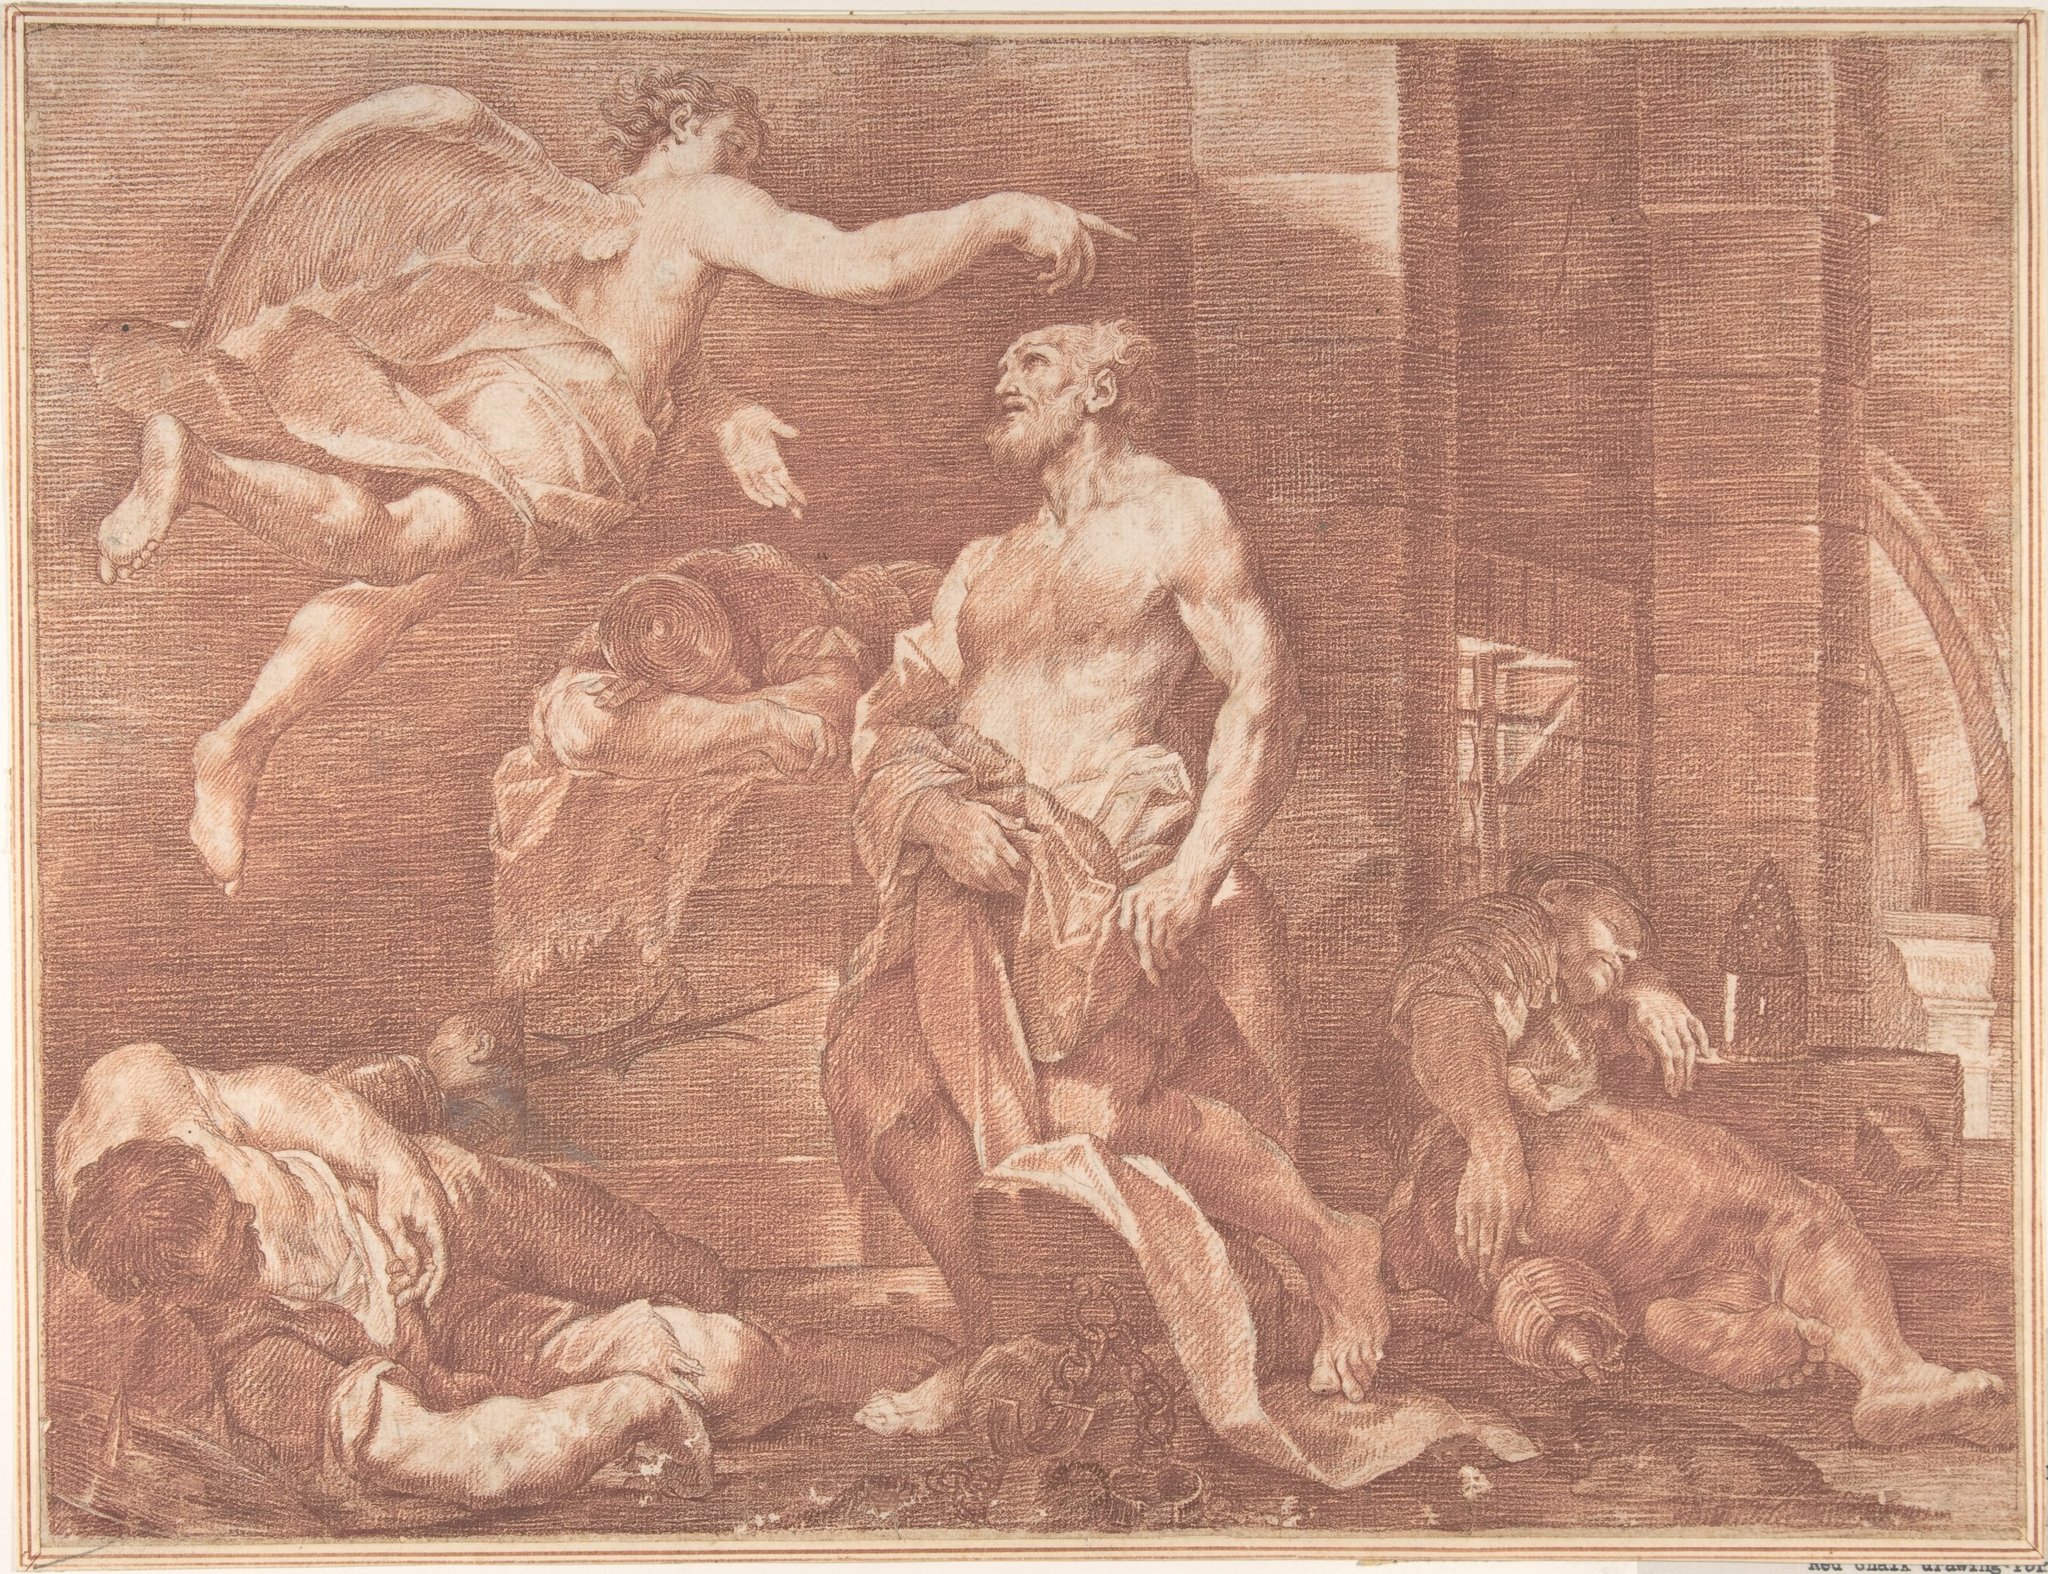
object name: drawing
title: Saint Peter Released from Prison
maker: anonymous, italian, bolognese, 17th century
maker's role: artist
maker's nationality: italian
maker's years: 1600-1700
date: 1601-1700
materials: chalk, paper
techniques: drawing, engraving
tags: prisons,prisoners,men,angels,saint peter